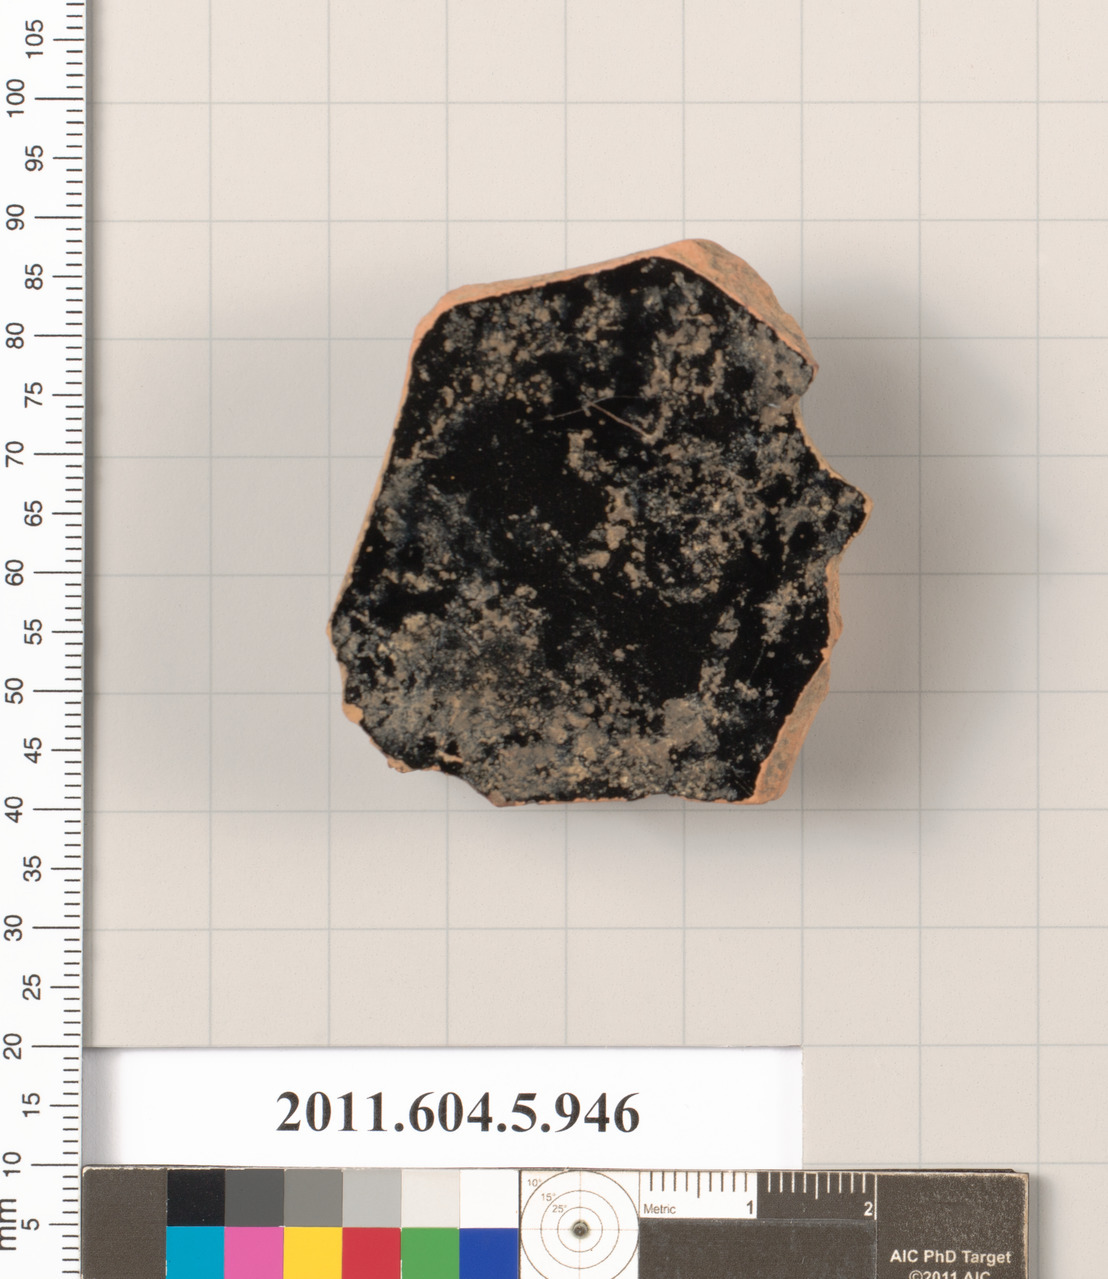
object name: kylix fragment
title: Terracotta fragment of a kylix (drinking cup)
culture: greek, attic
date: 600-401 BCE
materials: terracotta